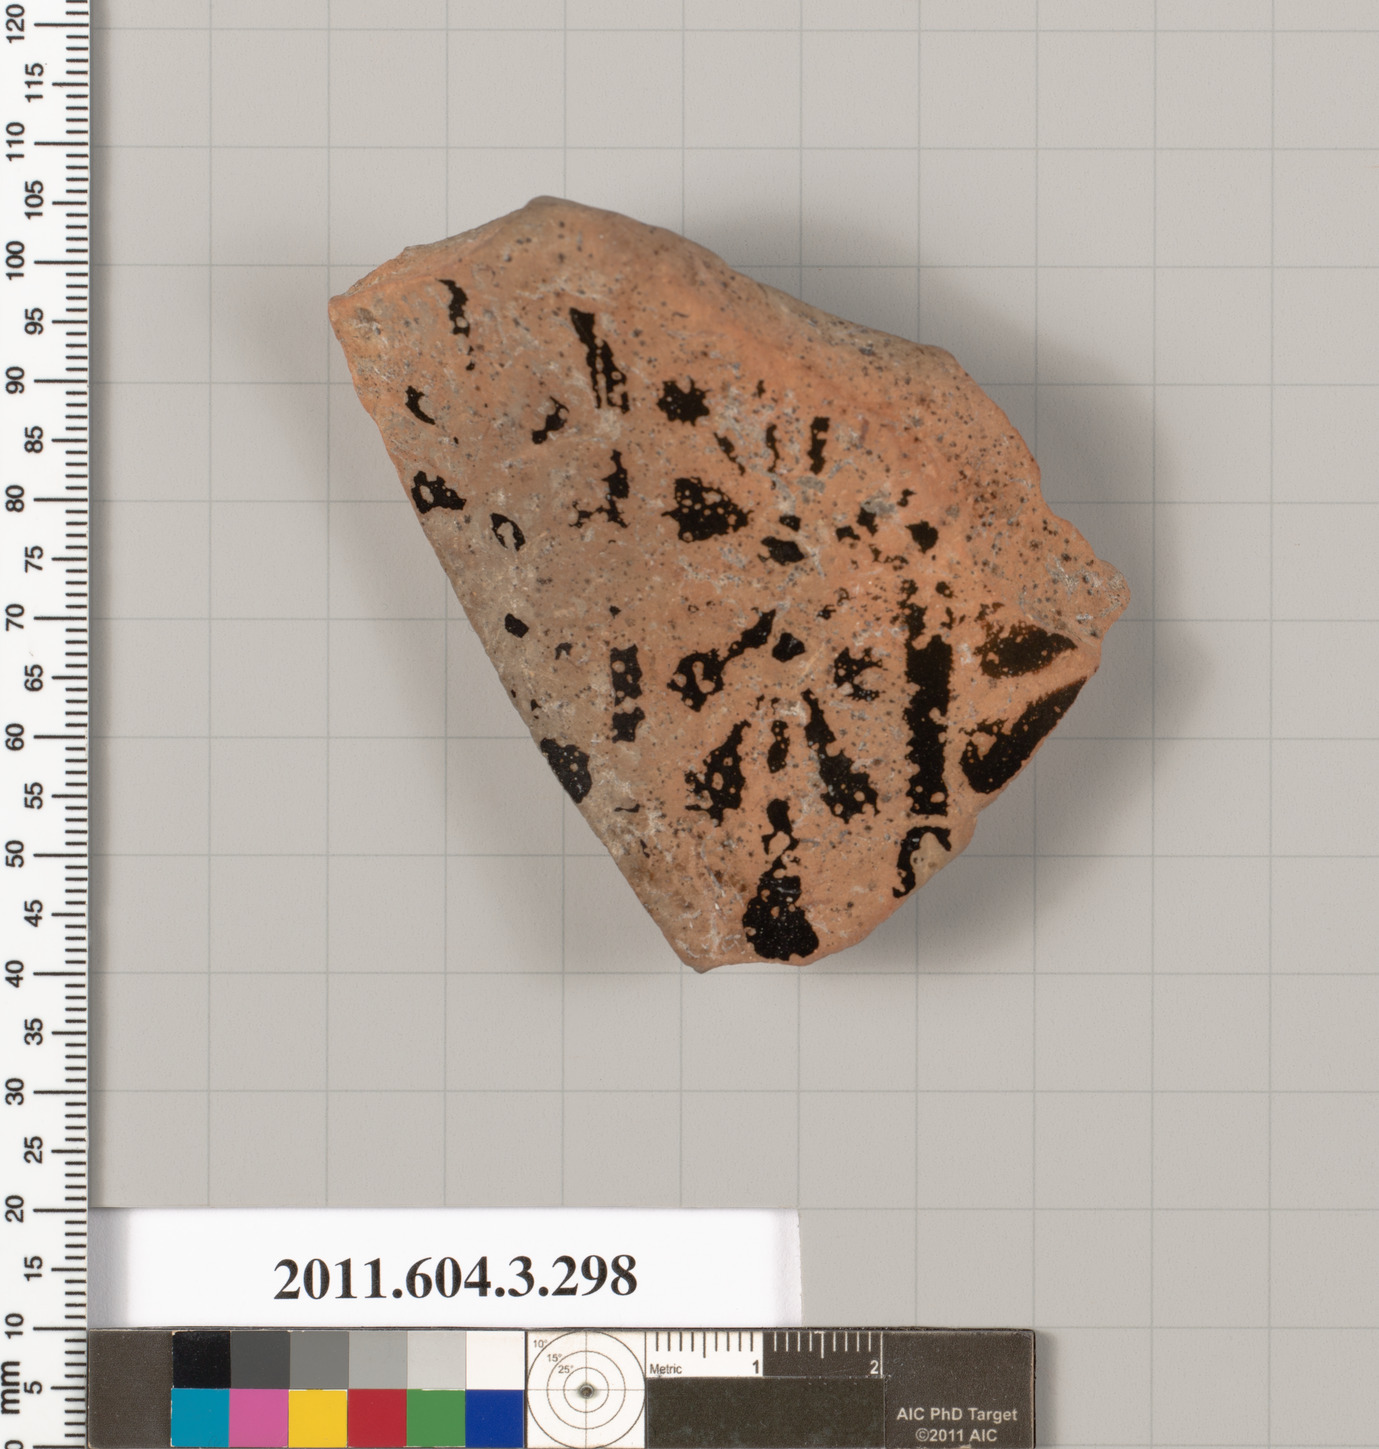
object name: neck amphora fragment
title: Terracotta fragment of a neck-amphora (jar)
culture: greek, attic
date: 520-510 BCE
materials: terracotta